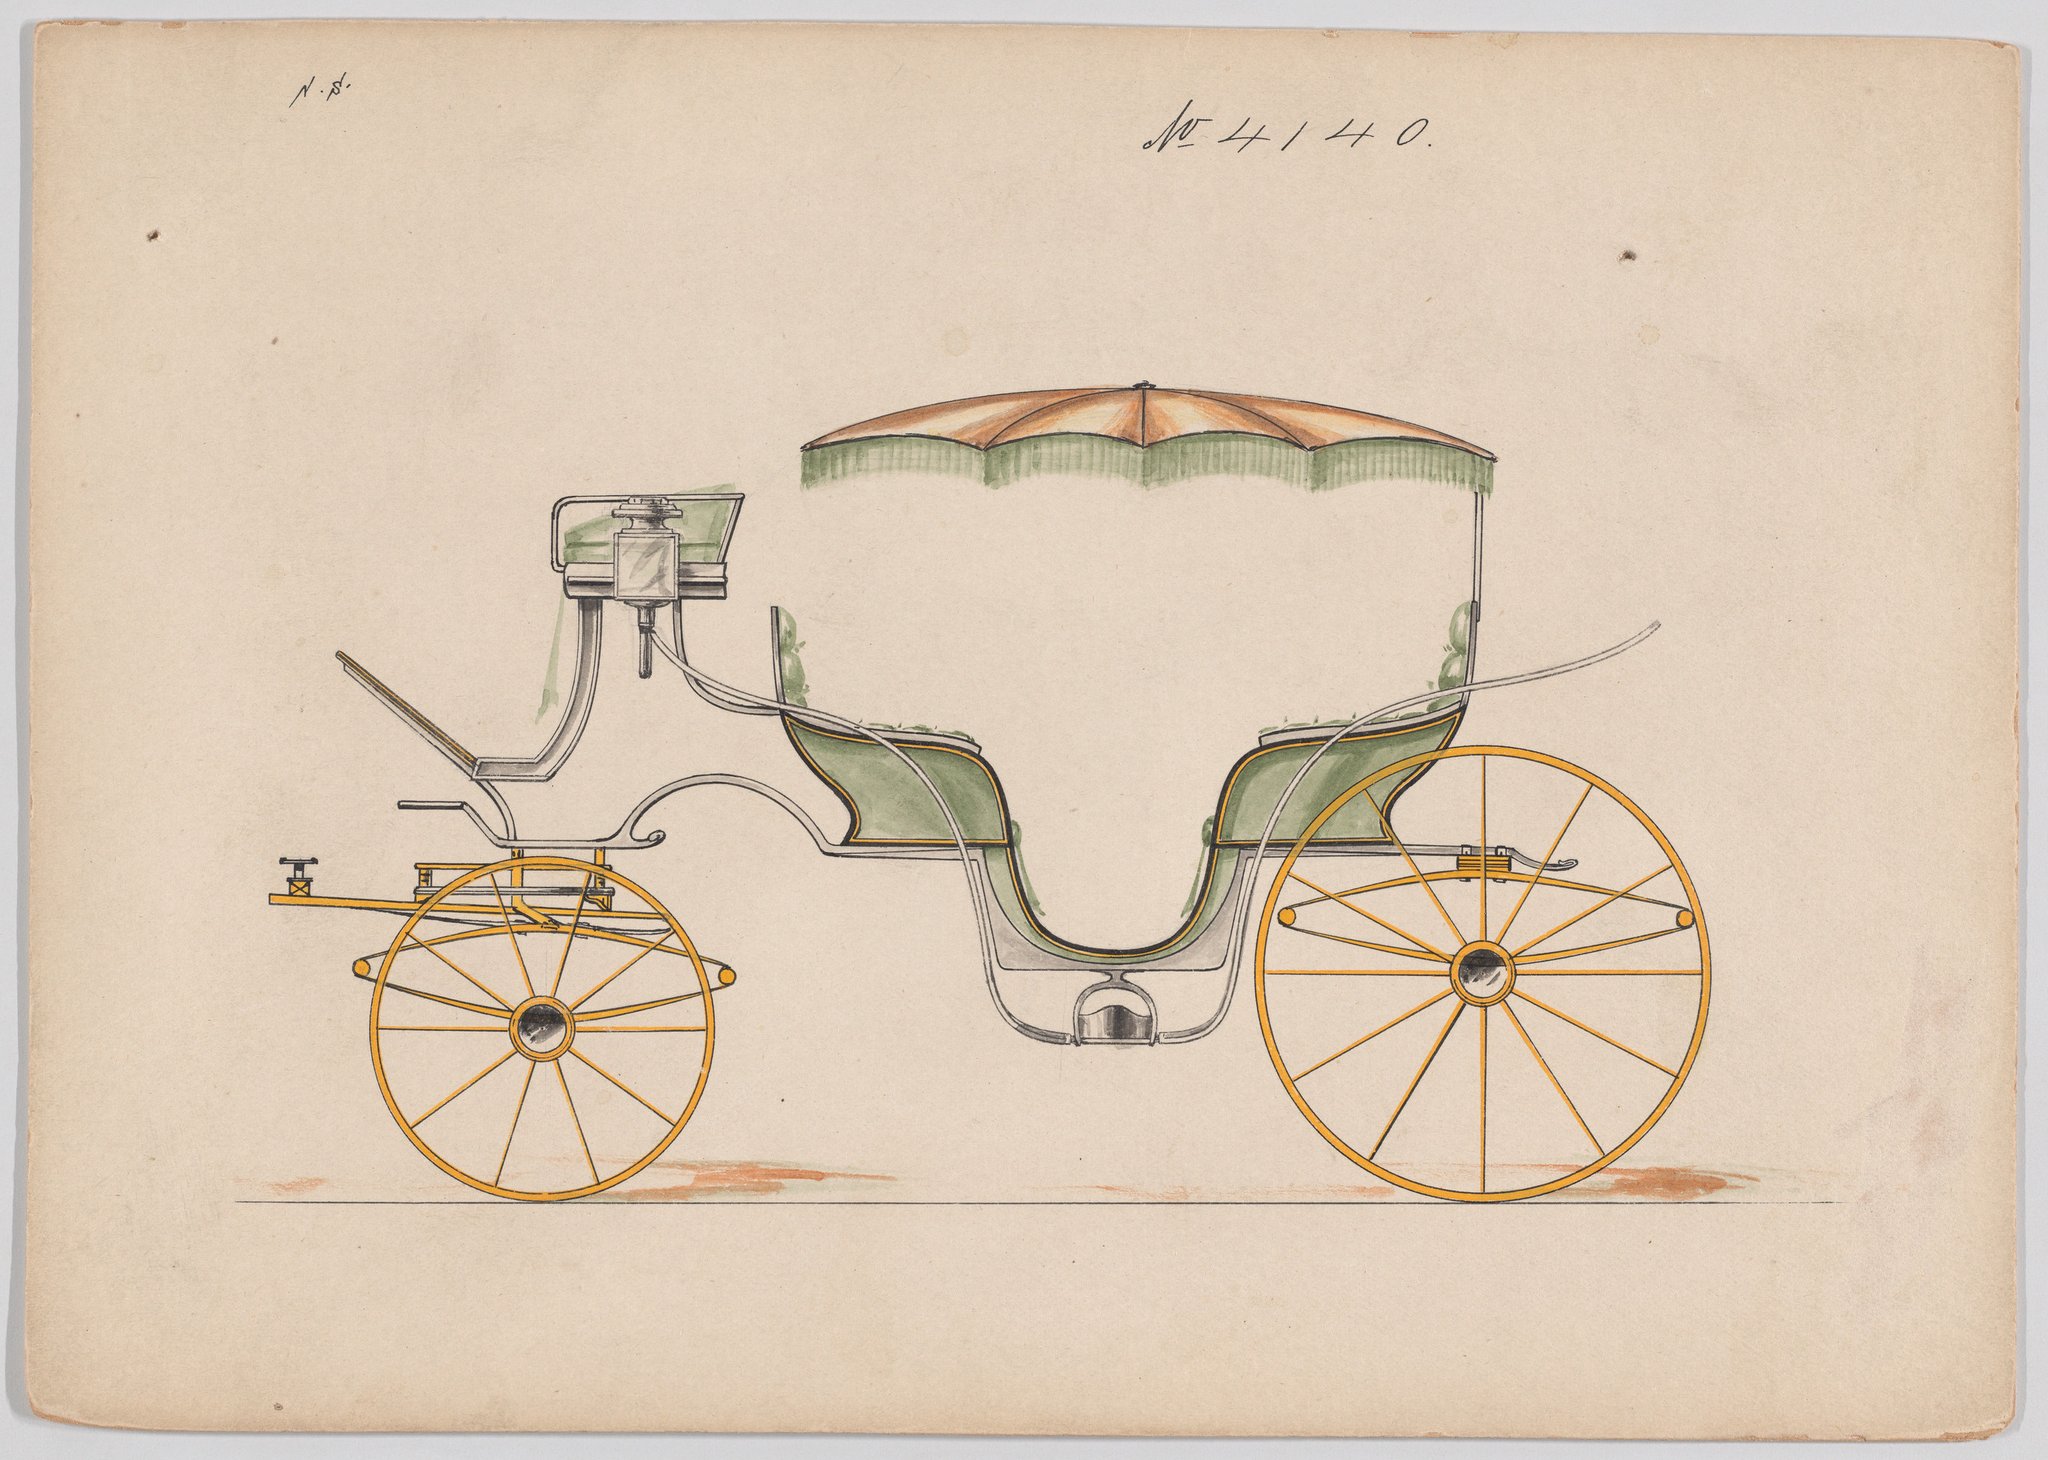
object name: drawing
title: Parasol-top Vis-à-Vis #4140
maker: brewster & co.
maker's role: manufacturer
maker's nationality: american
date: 1891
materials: gouache, ink, watercolor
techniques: pen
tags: carriages